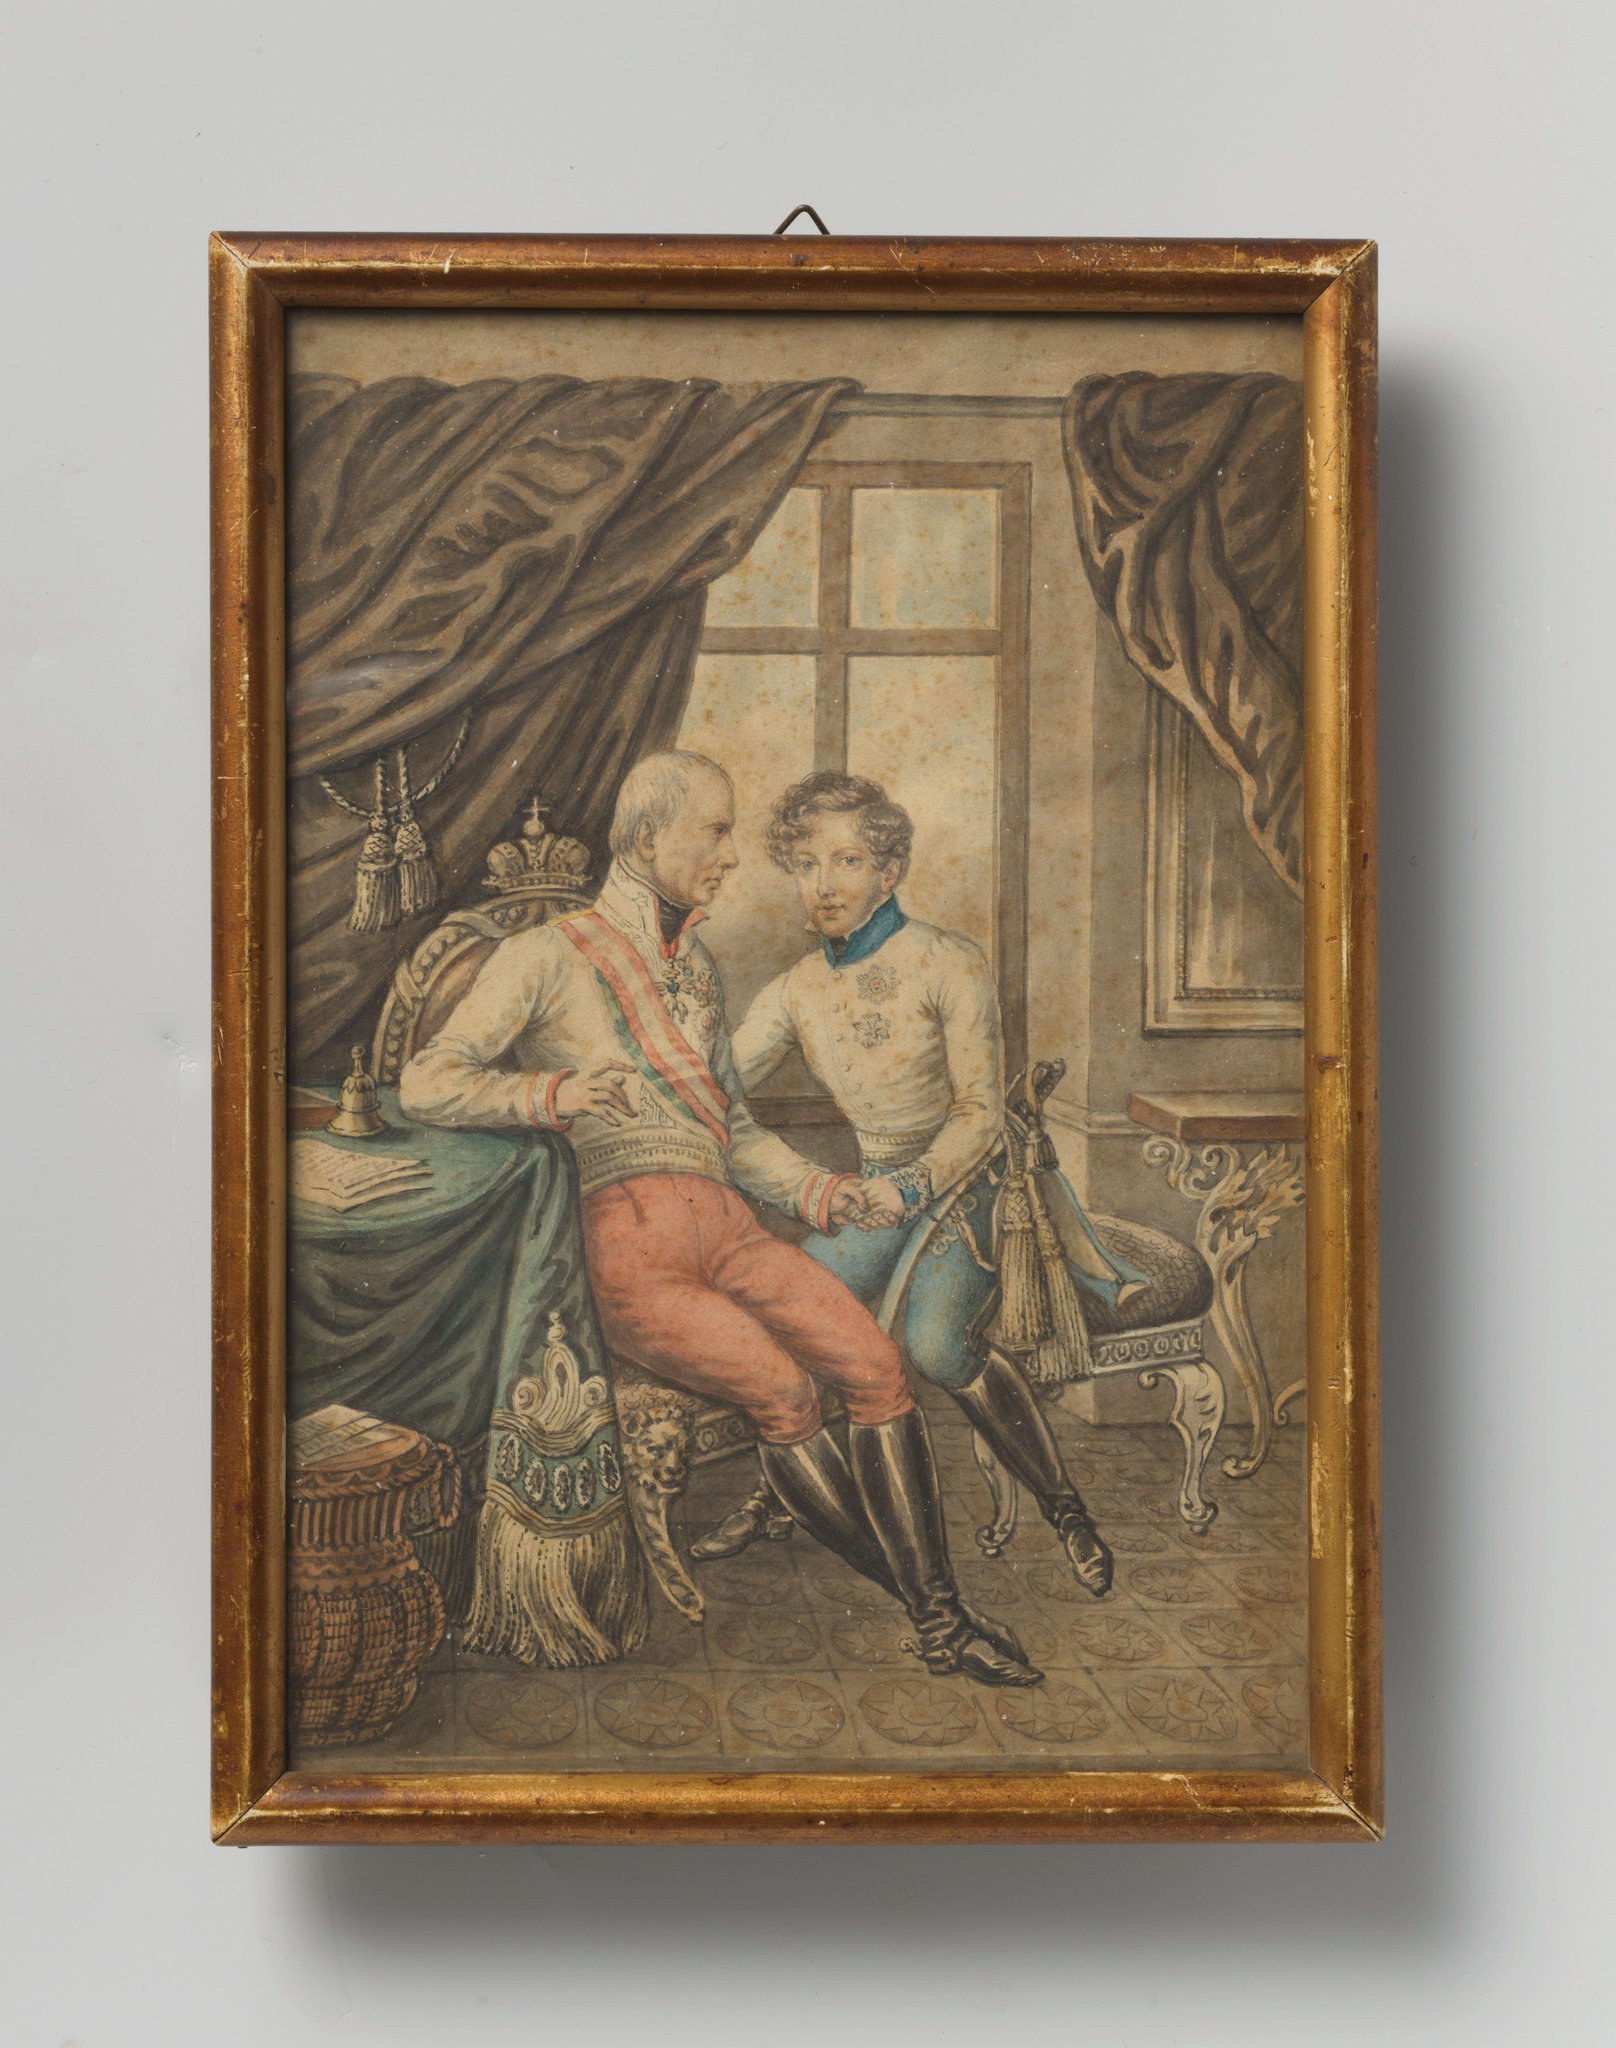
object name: drawing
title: Portret keizer Frans I van Oostenrijk en hertog van Reichstadt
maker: schijtra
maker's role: draughtsman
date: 1800-1900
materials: glass, ink, paint, paper, watercolor, wood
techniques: framing, painted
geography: austria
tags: paris, vienna, frans ii (rooms-duits keizer), historical persons, austria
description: In vergulde lijst vervatte tekening, twee mannen, hand in hand, gezeten op versierd stoelen in kamer, in uniform. Achterzijde, tekst: "Le duc de Reichstadt avec son Grand-Père l'Empereur..." .(slecht leesbaar) (in potlood). Volgens jaarverslag 1960 betreft het hier Keizer Frans I van Oostenrijk en zijn kleinzoon, de hertog van Reichstadt.